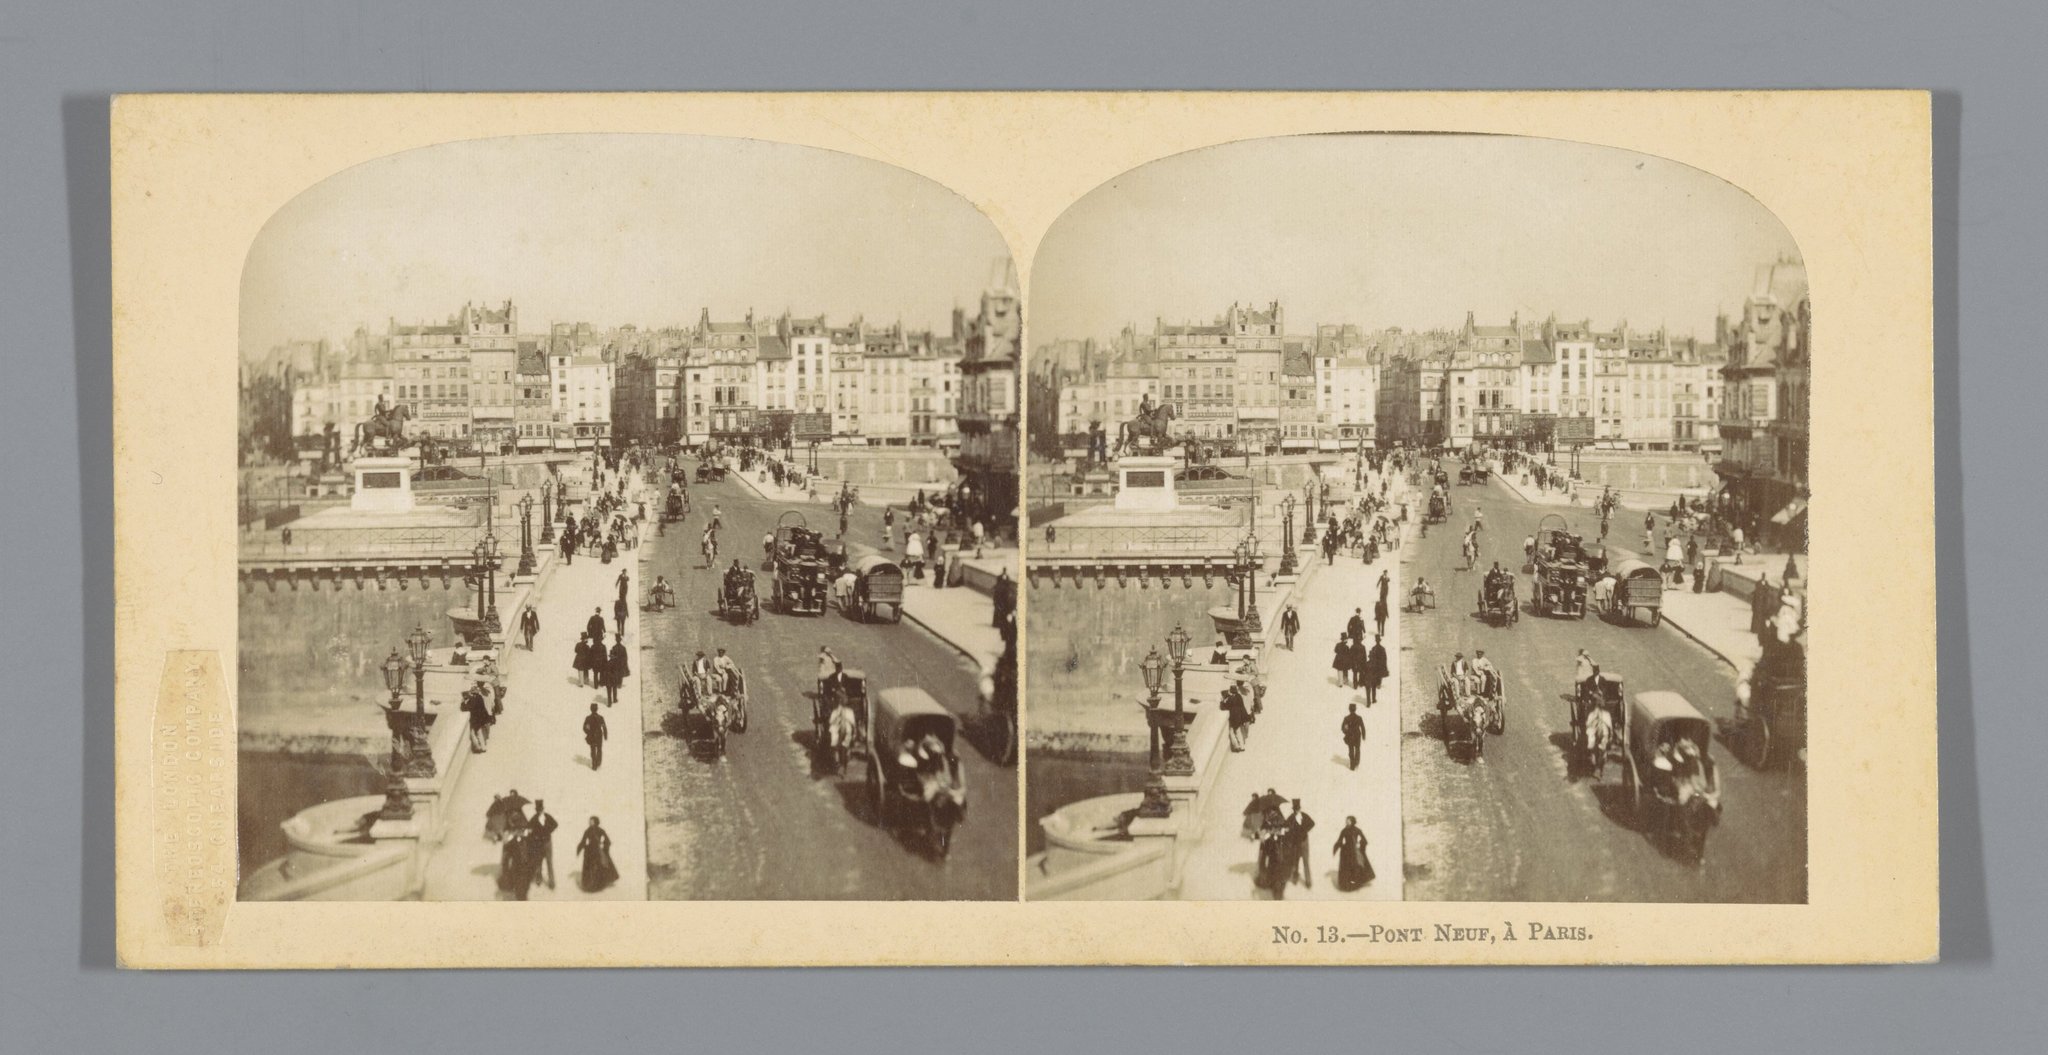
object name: stereograph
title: Pont Neuf, à Paris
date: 1850-1875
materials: cardboard, photographic support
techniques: albumen print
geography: paris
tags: bridge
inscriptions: number: ‘No. 13.’